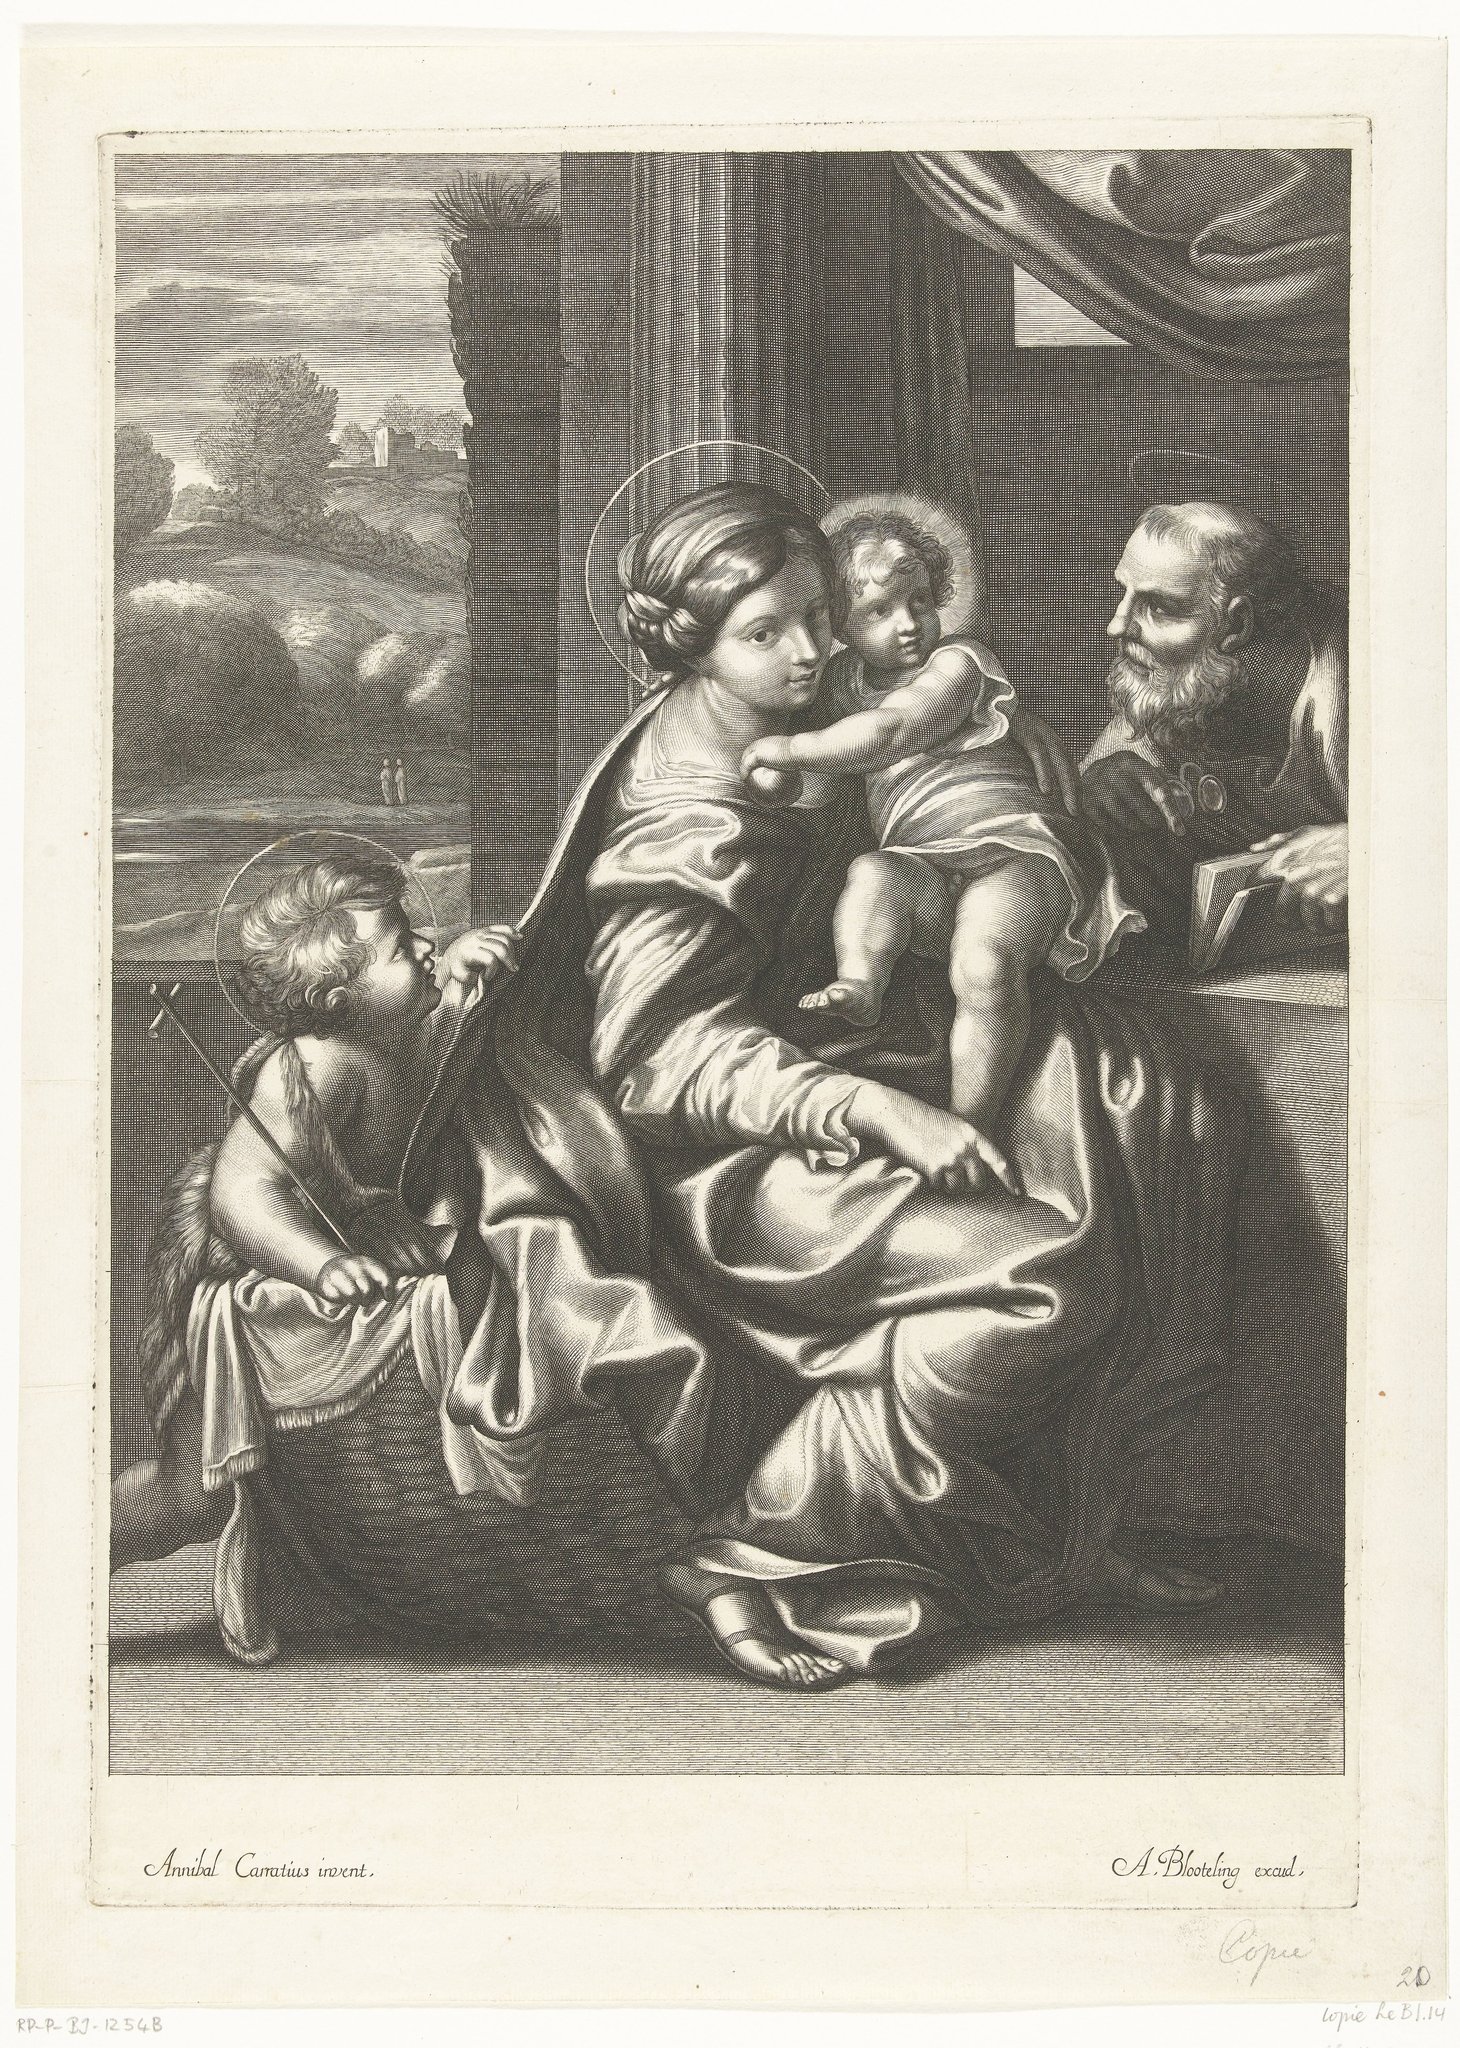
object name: print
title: Heilige Familie met Johannes de Doper als kind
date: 1655-1690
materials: paper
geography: amsterdam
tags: holy family with john the baptist (as child)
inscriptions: collector's mark: Lugt 240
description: De Heilige Familie: aan een venster zit Maria met het Christuskind op schoot. Het Christuskind heeft een appel in zijn linkerhand. Achter Maria trekt Johannes de Doper aan de kleding van Maria en kijkt naar haar op. Aan de andere zijde van het venster heeft Jozef een bril in zijn rechterhand en een boek in zijn linkerhand. Jozef kijkt naar het Christuskind.